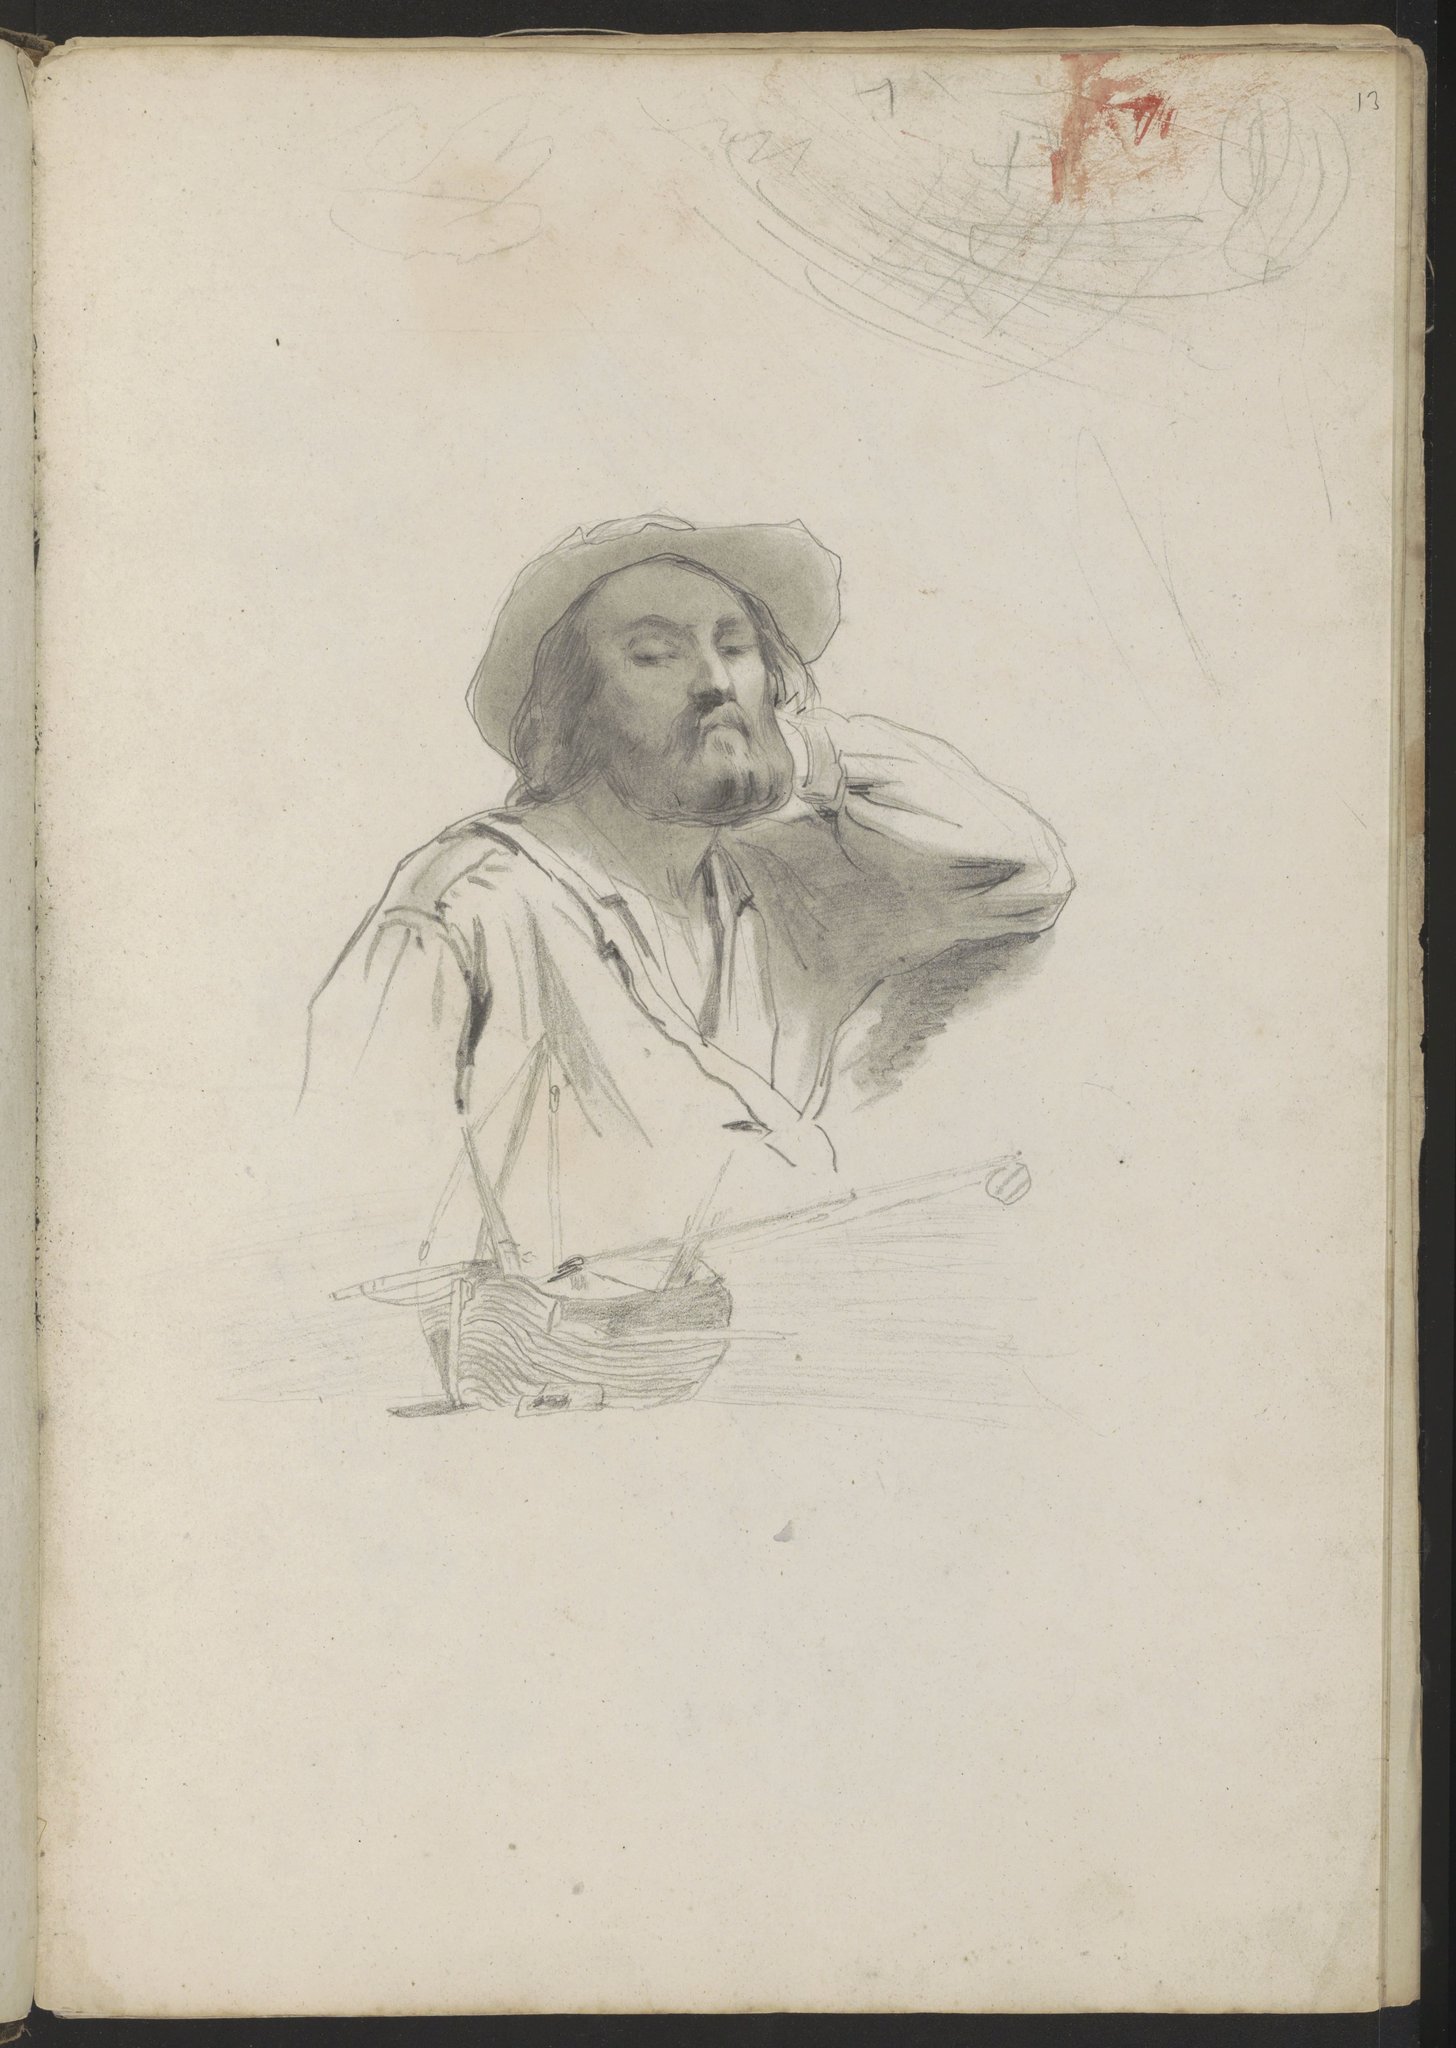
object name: sketchbook leaf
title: Zeilboot en een man met een baard en hoed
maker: johannes huybertus van hove bzn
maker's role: print maker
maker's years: 1827-1881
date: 1837-1881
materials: paper, pencil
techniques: stumping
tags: head (human), sailing-ship, sailing-boat, head-gear: hat (+ men's clothes), beard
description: Blad 13 recto uit een schetsboek met 33 bladen en 10 losse tekeningen.